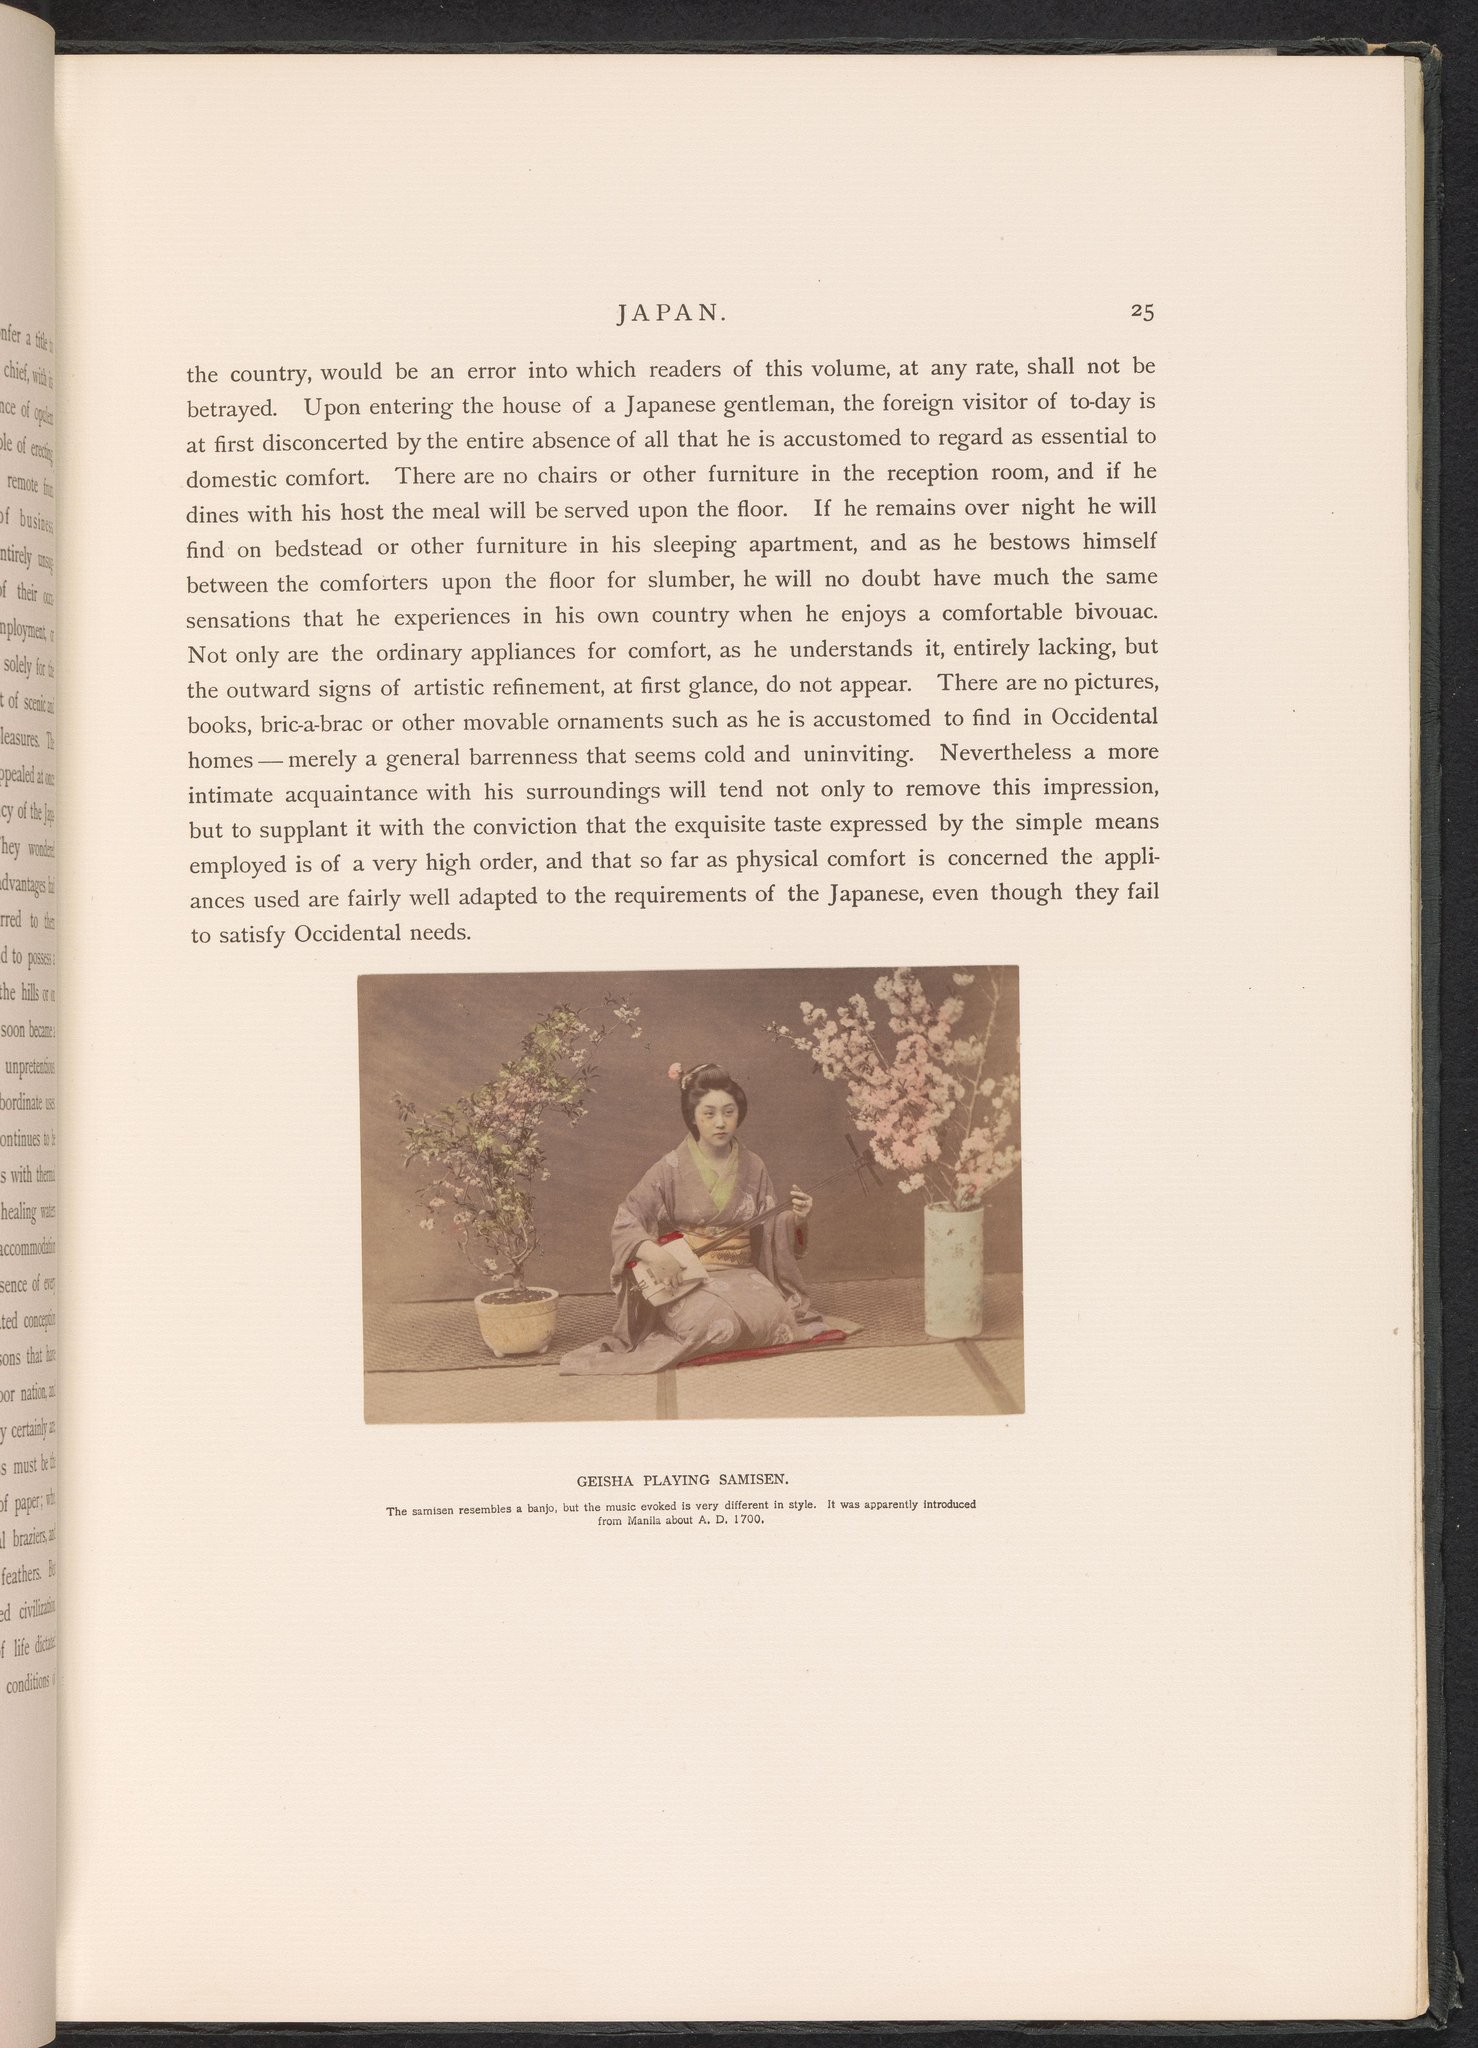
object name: page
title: Geisha playing samisen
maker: Anonymous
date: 1887-1897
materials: photographic support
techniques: albumen print, hand coloring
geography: japan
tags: string instruments (plucked), folk costume, regional costume, dress, gown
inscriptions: inscription: ‘The samisen resembles a banjo, but the music evoked is very different in style. It was apparently introduced from Manila about A. D. 1700.’